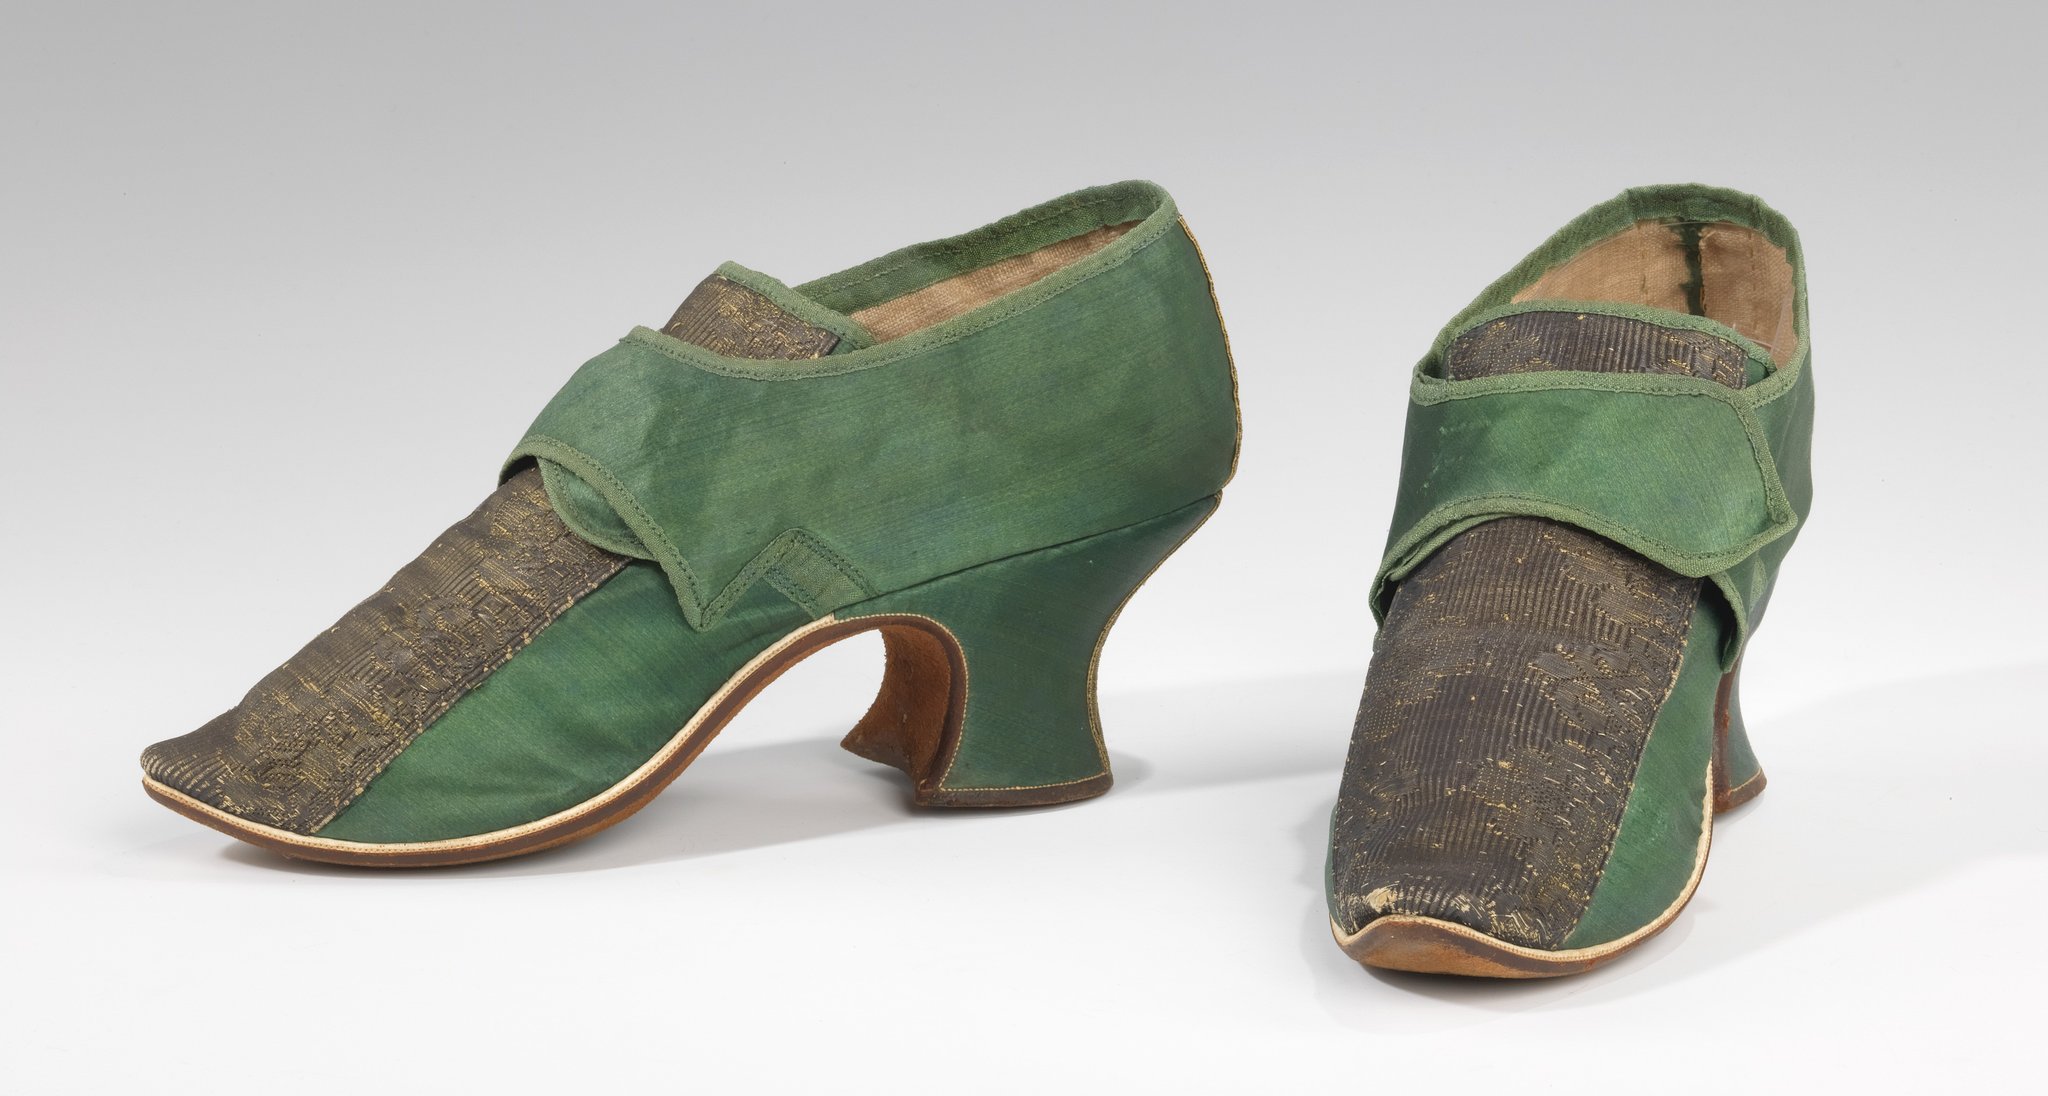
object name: shoe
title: Shoes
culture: british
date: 1730-1755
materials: metal, silk